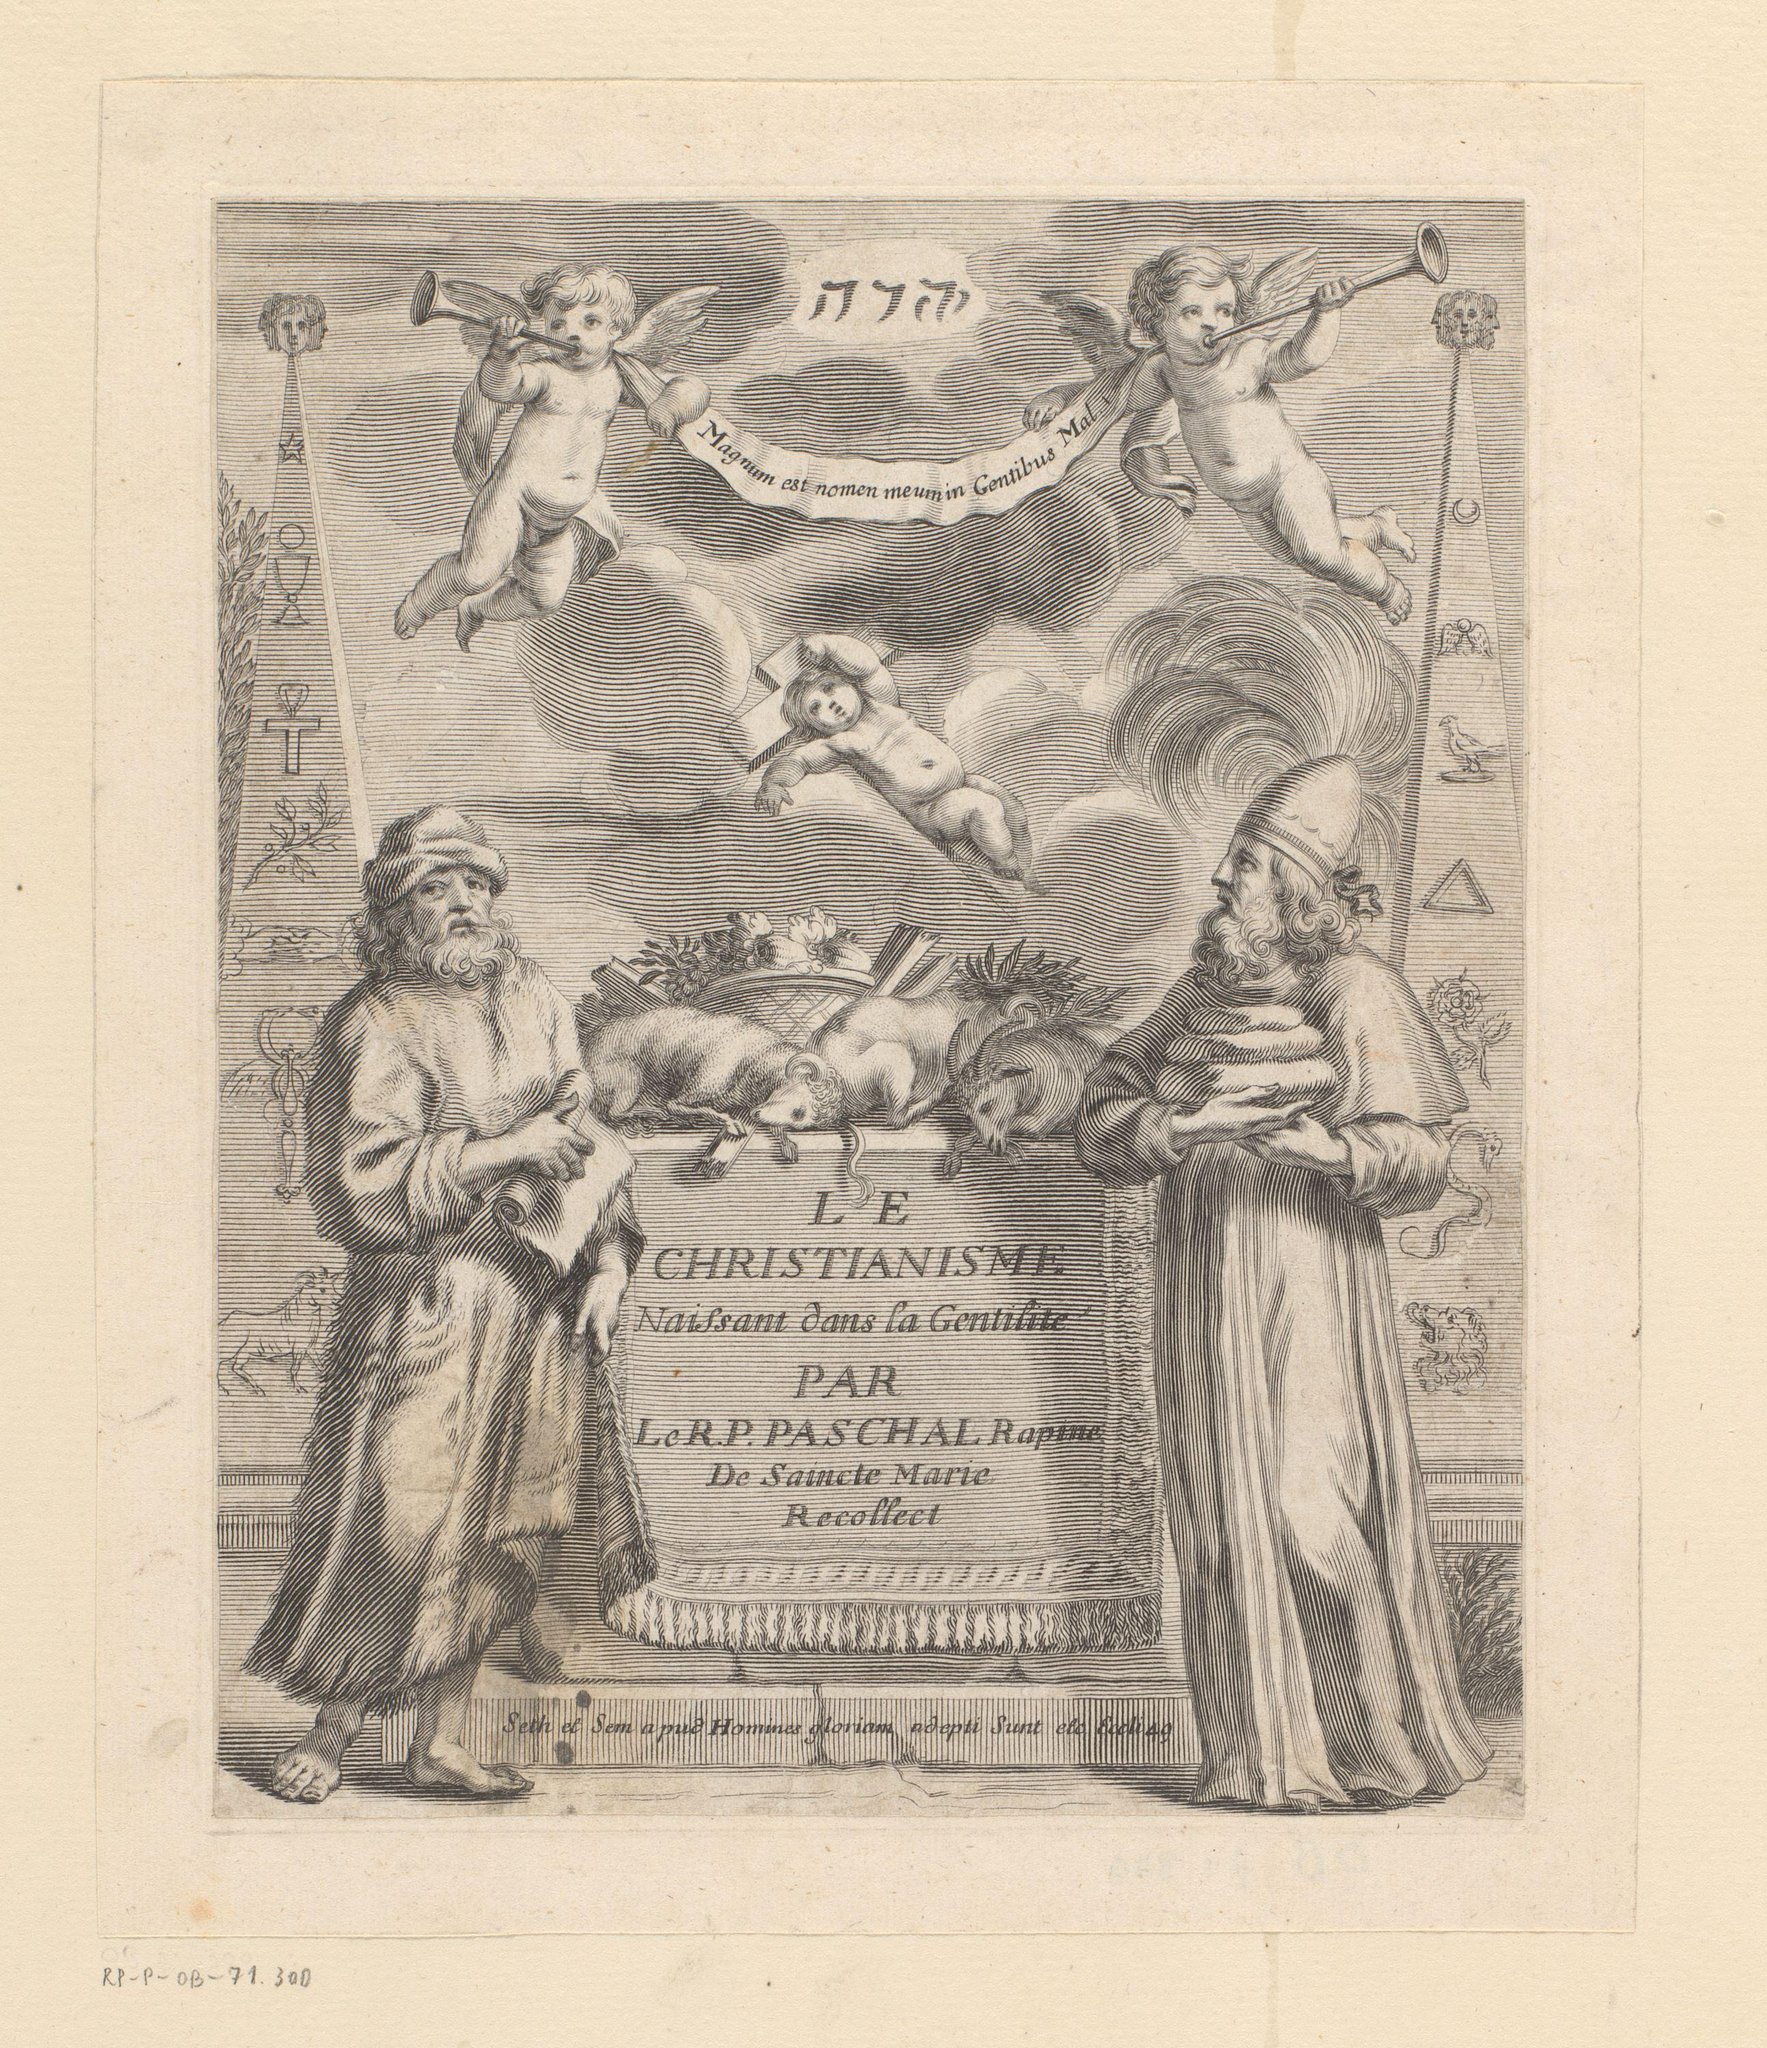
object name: print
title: Titelpagina voor: Paschal Rapine de Sainte-Marie, Le Christianisme naissant dans la Gentilité, 1655-1659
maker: claude mellan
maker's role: draughtsman, print maker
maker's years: 1598-1688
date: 1655-1659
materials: paper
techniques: engraving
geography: france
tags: story of seth, obelisk, needle, he-goat, billy-goat, altar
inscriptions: collector's mark: Lugt 240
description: Titelpagina voor: Rapine de Sainte-Marie, Paschal. Le Christianisme naissant dans la Gentilité. Parijs (?): Couterot, 1655-1659.